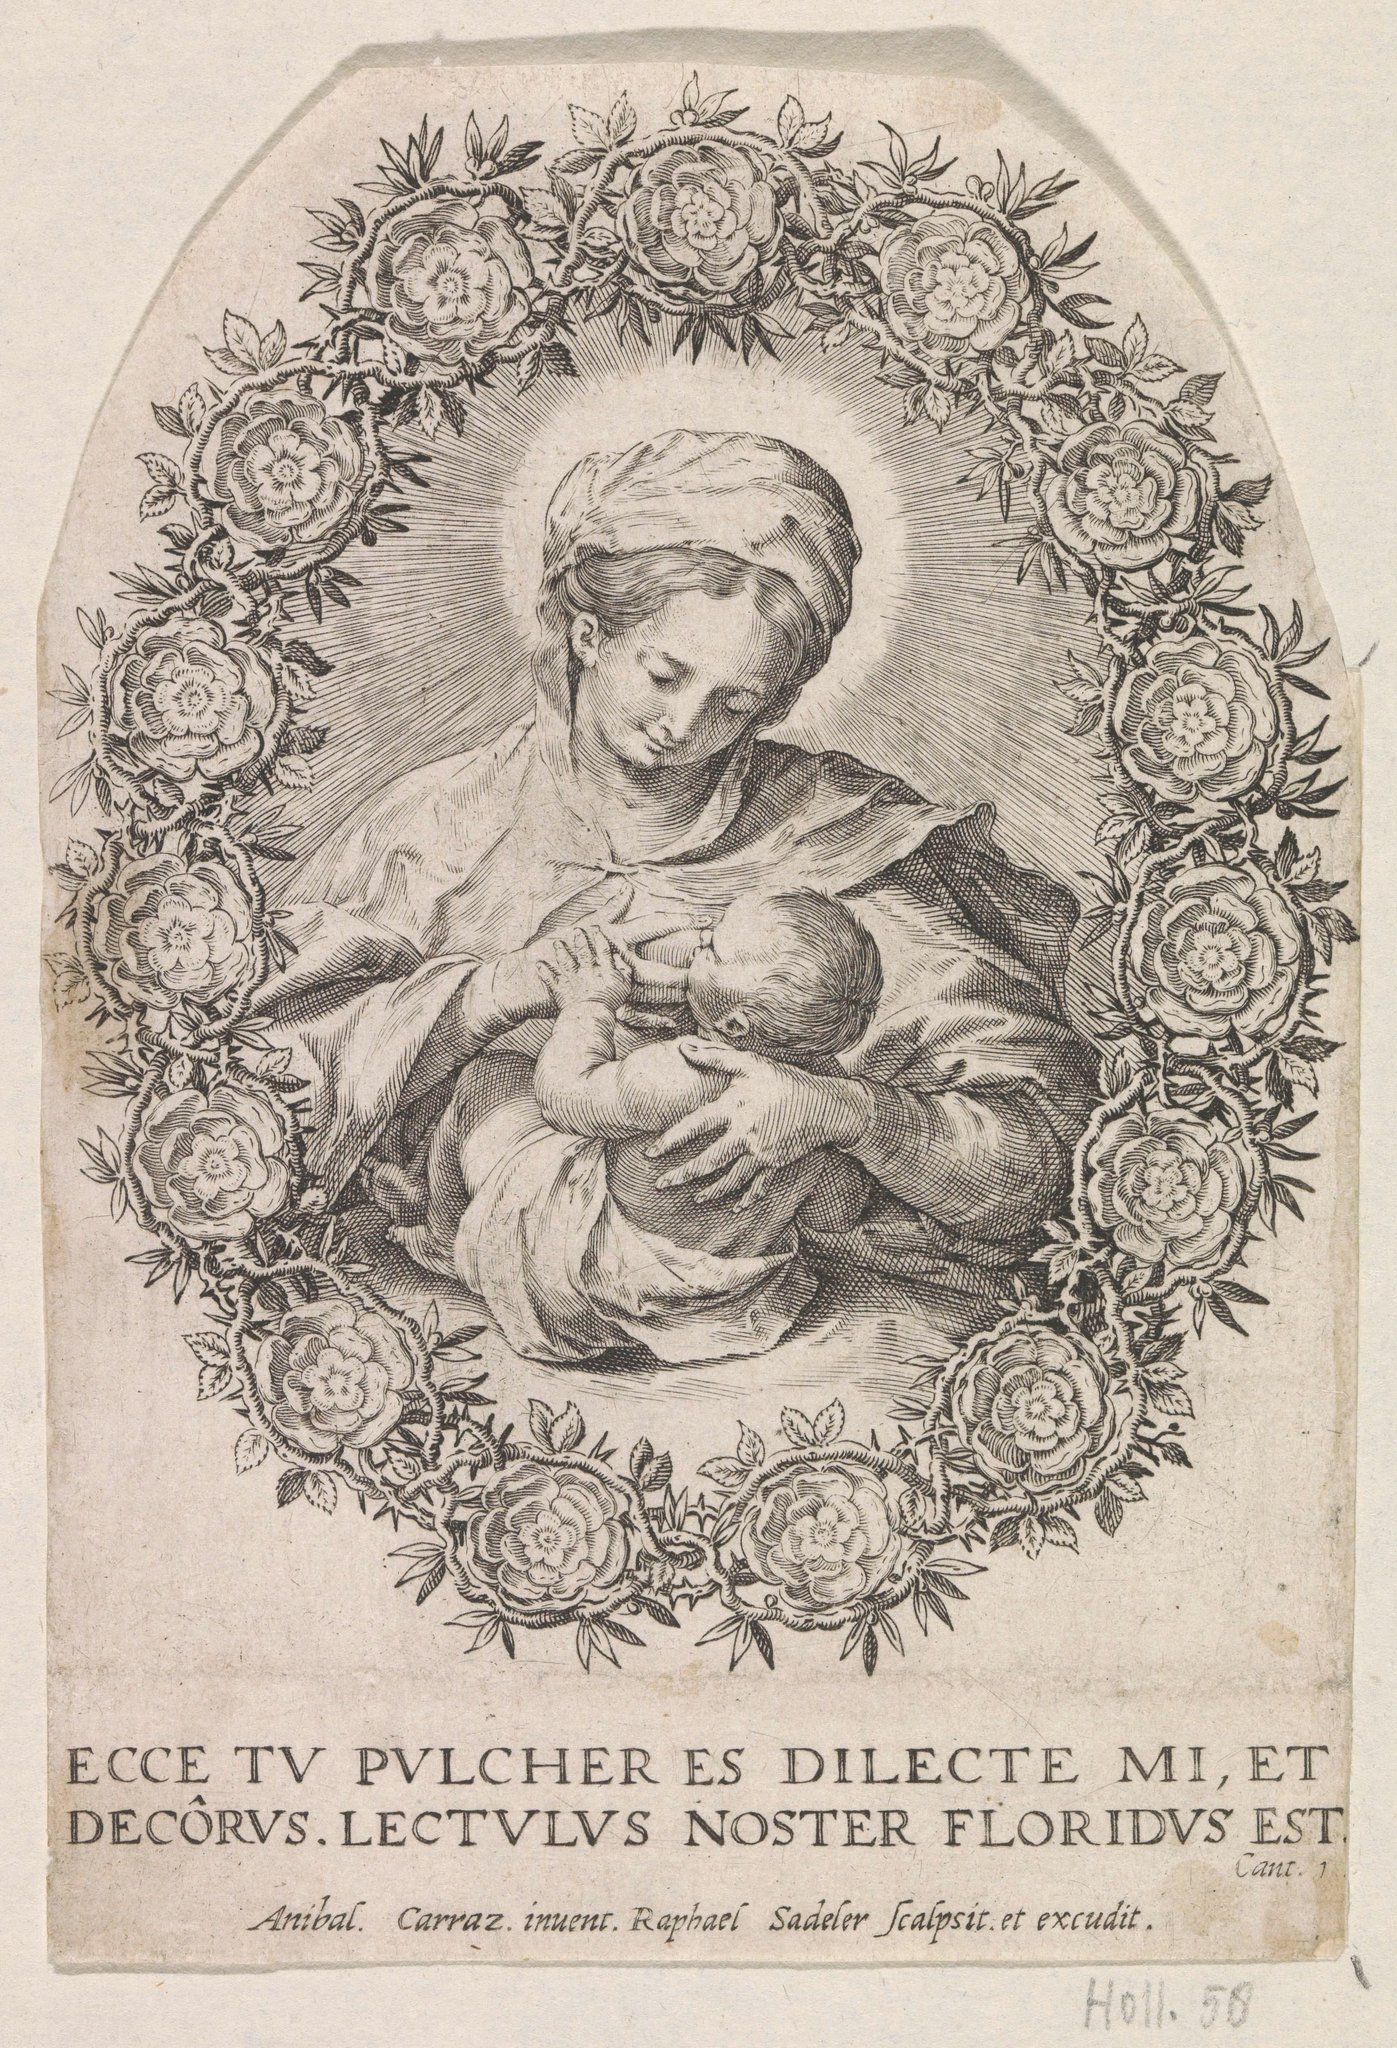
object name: print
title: Maria zoogt het Christuskind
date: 1570-1628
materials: paper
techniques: engraving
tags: christ-child suckling, or beginning to suckle, e.g. mary uncovering her breast ~ madonna-representations, flowers: rose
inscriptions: collector's mark: Lugt 2228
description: De maagd Maria zoogt het Christuskind. Rondom hen een krans van rozen.